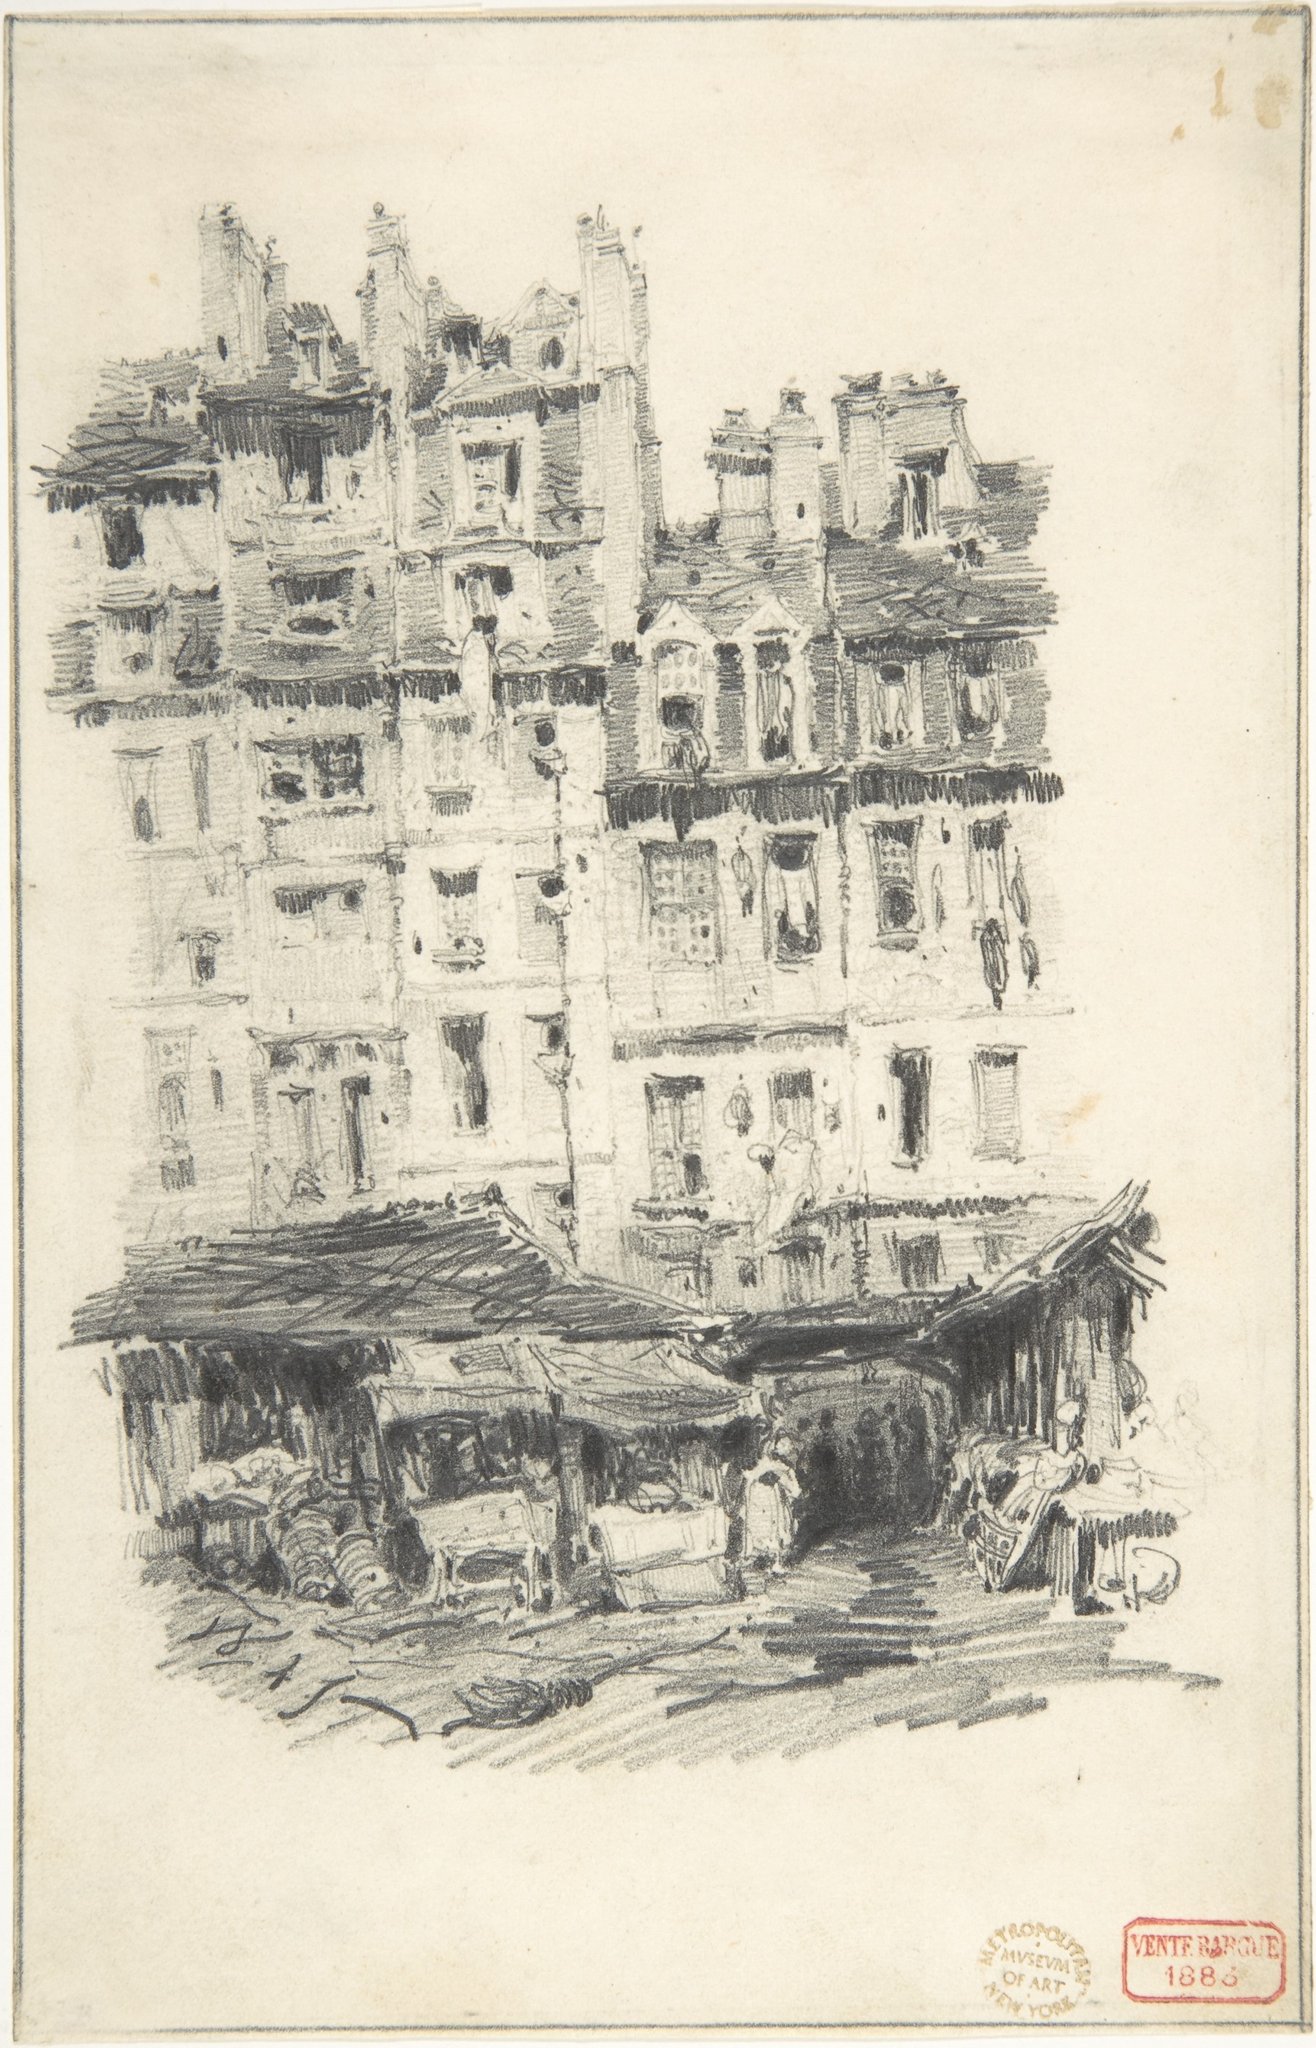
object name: drawing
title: Houses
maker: charles bargue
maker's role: artist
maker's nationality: french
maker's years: 1825-1883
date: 1845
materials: graphite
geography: france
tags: houses